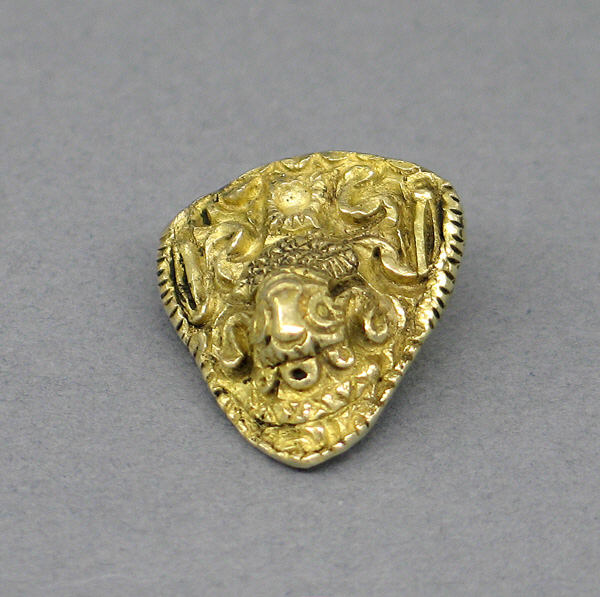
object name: finial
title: Rod Finial with Zoomorphic Motif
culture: indonesian, javanese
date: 1801-2000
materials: gold